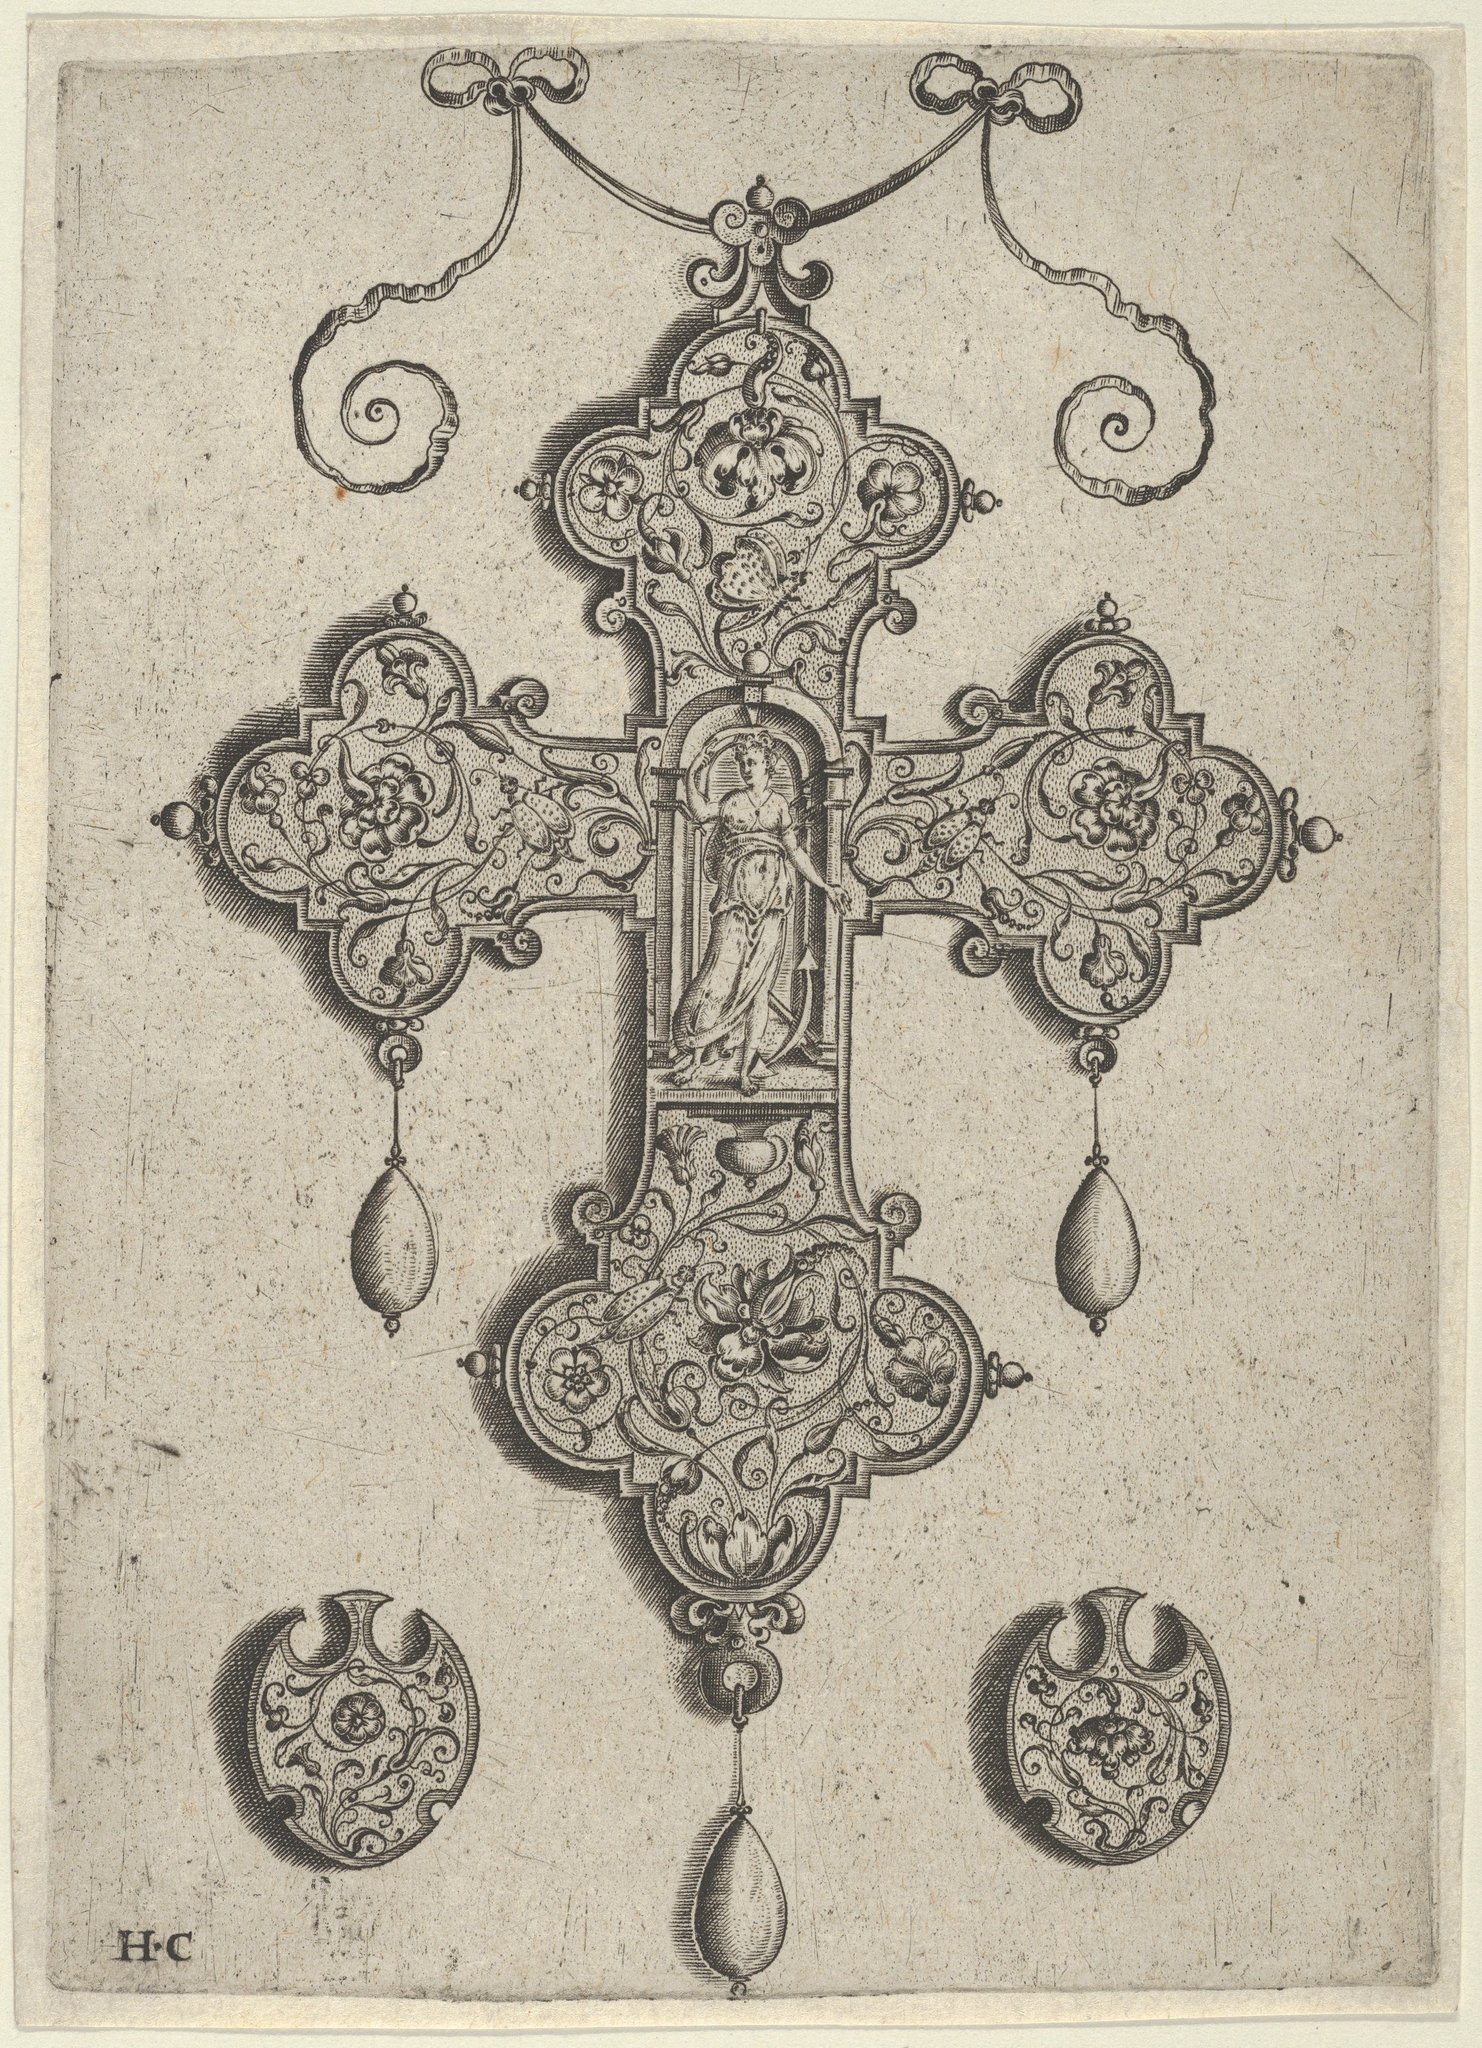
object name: print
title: Cross-Shaped Pendant Design with Hope Standing in a Circular Temple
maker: jan collaert i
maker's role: artist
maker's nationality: netherlandish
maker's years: 1530-1581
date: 1573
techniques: engraving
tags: pendants